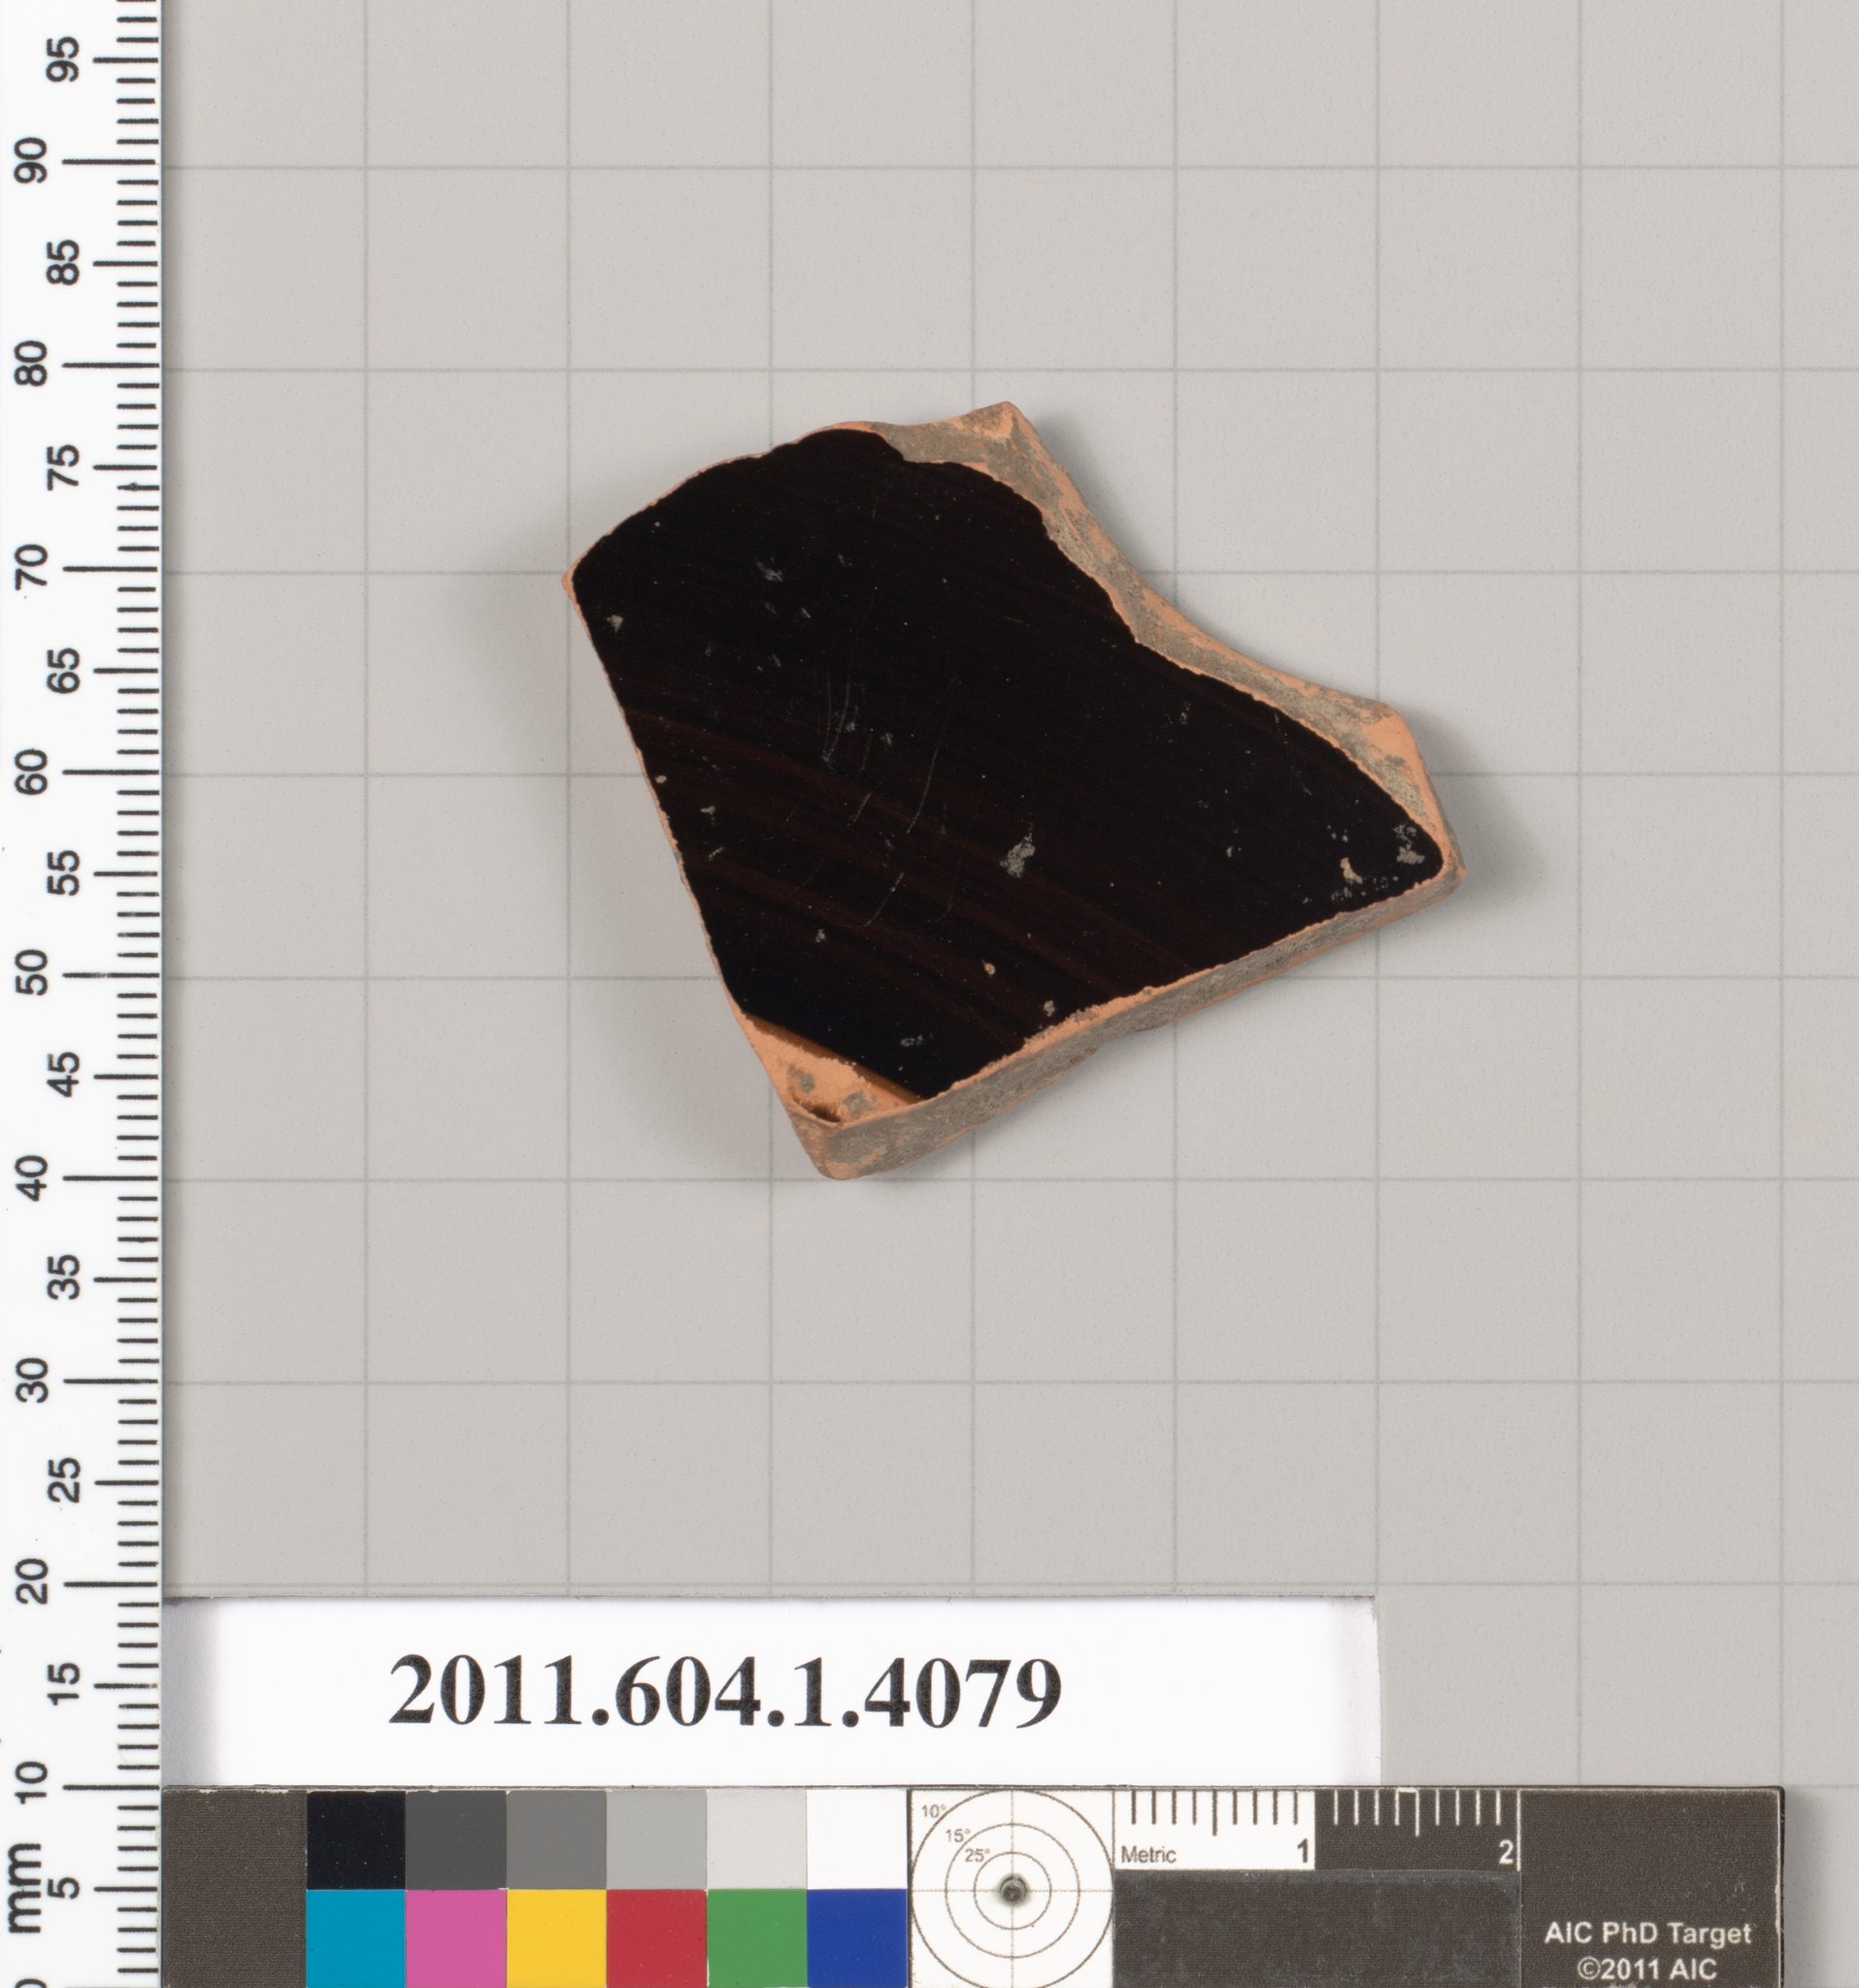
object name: kylix fragment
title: Terracotta fragment of a kylix (drinking cup)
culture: greek, attic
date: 490-480 BCE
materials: terracotta